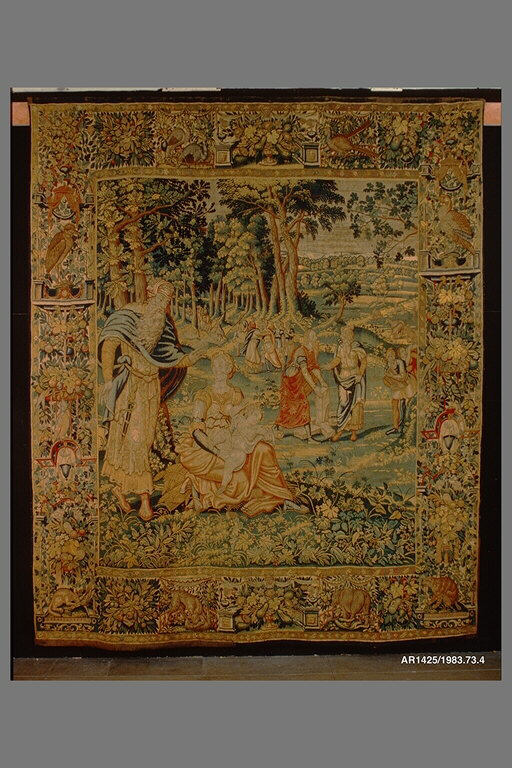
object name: tapestry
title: Laban Looking for the Images and Making a Covenant with Jacob from The Story of Jacob series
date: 1550-1575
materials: silk, wool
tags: grotesques,men,women,parrots,pheasants,elephants,foxes,leopards,sheep